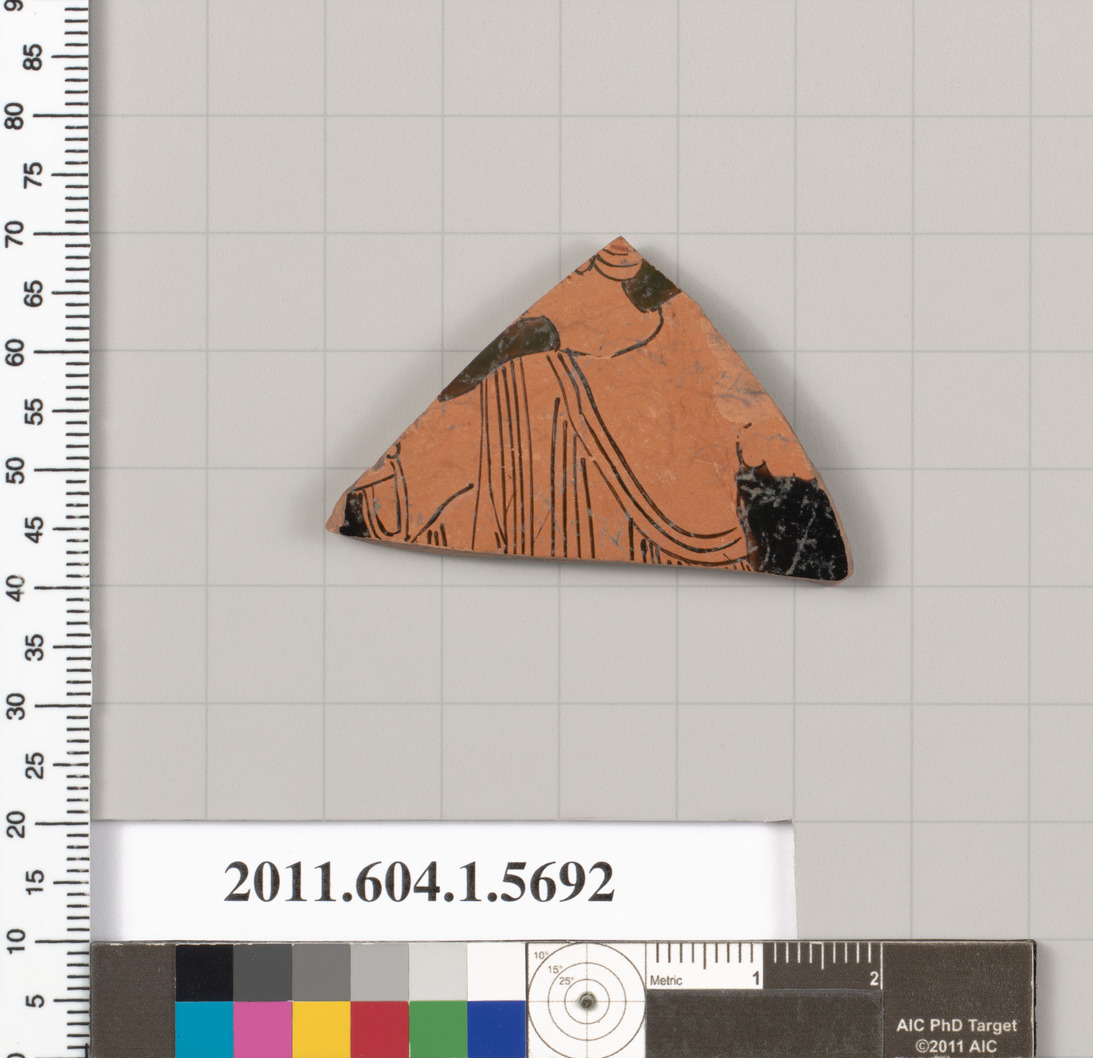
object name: kylix fragment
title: Terracotta fragment of a kylix (drinking cup)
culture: greek, attic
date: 475-451 BCE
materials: terracotta